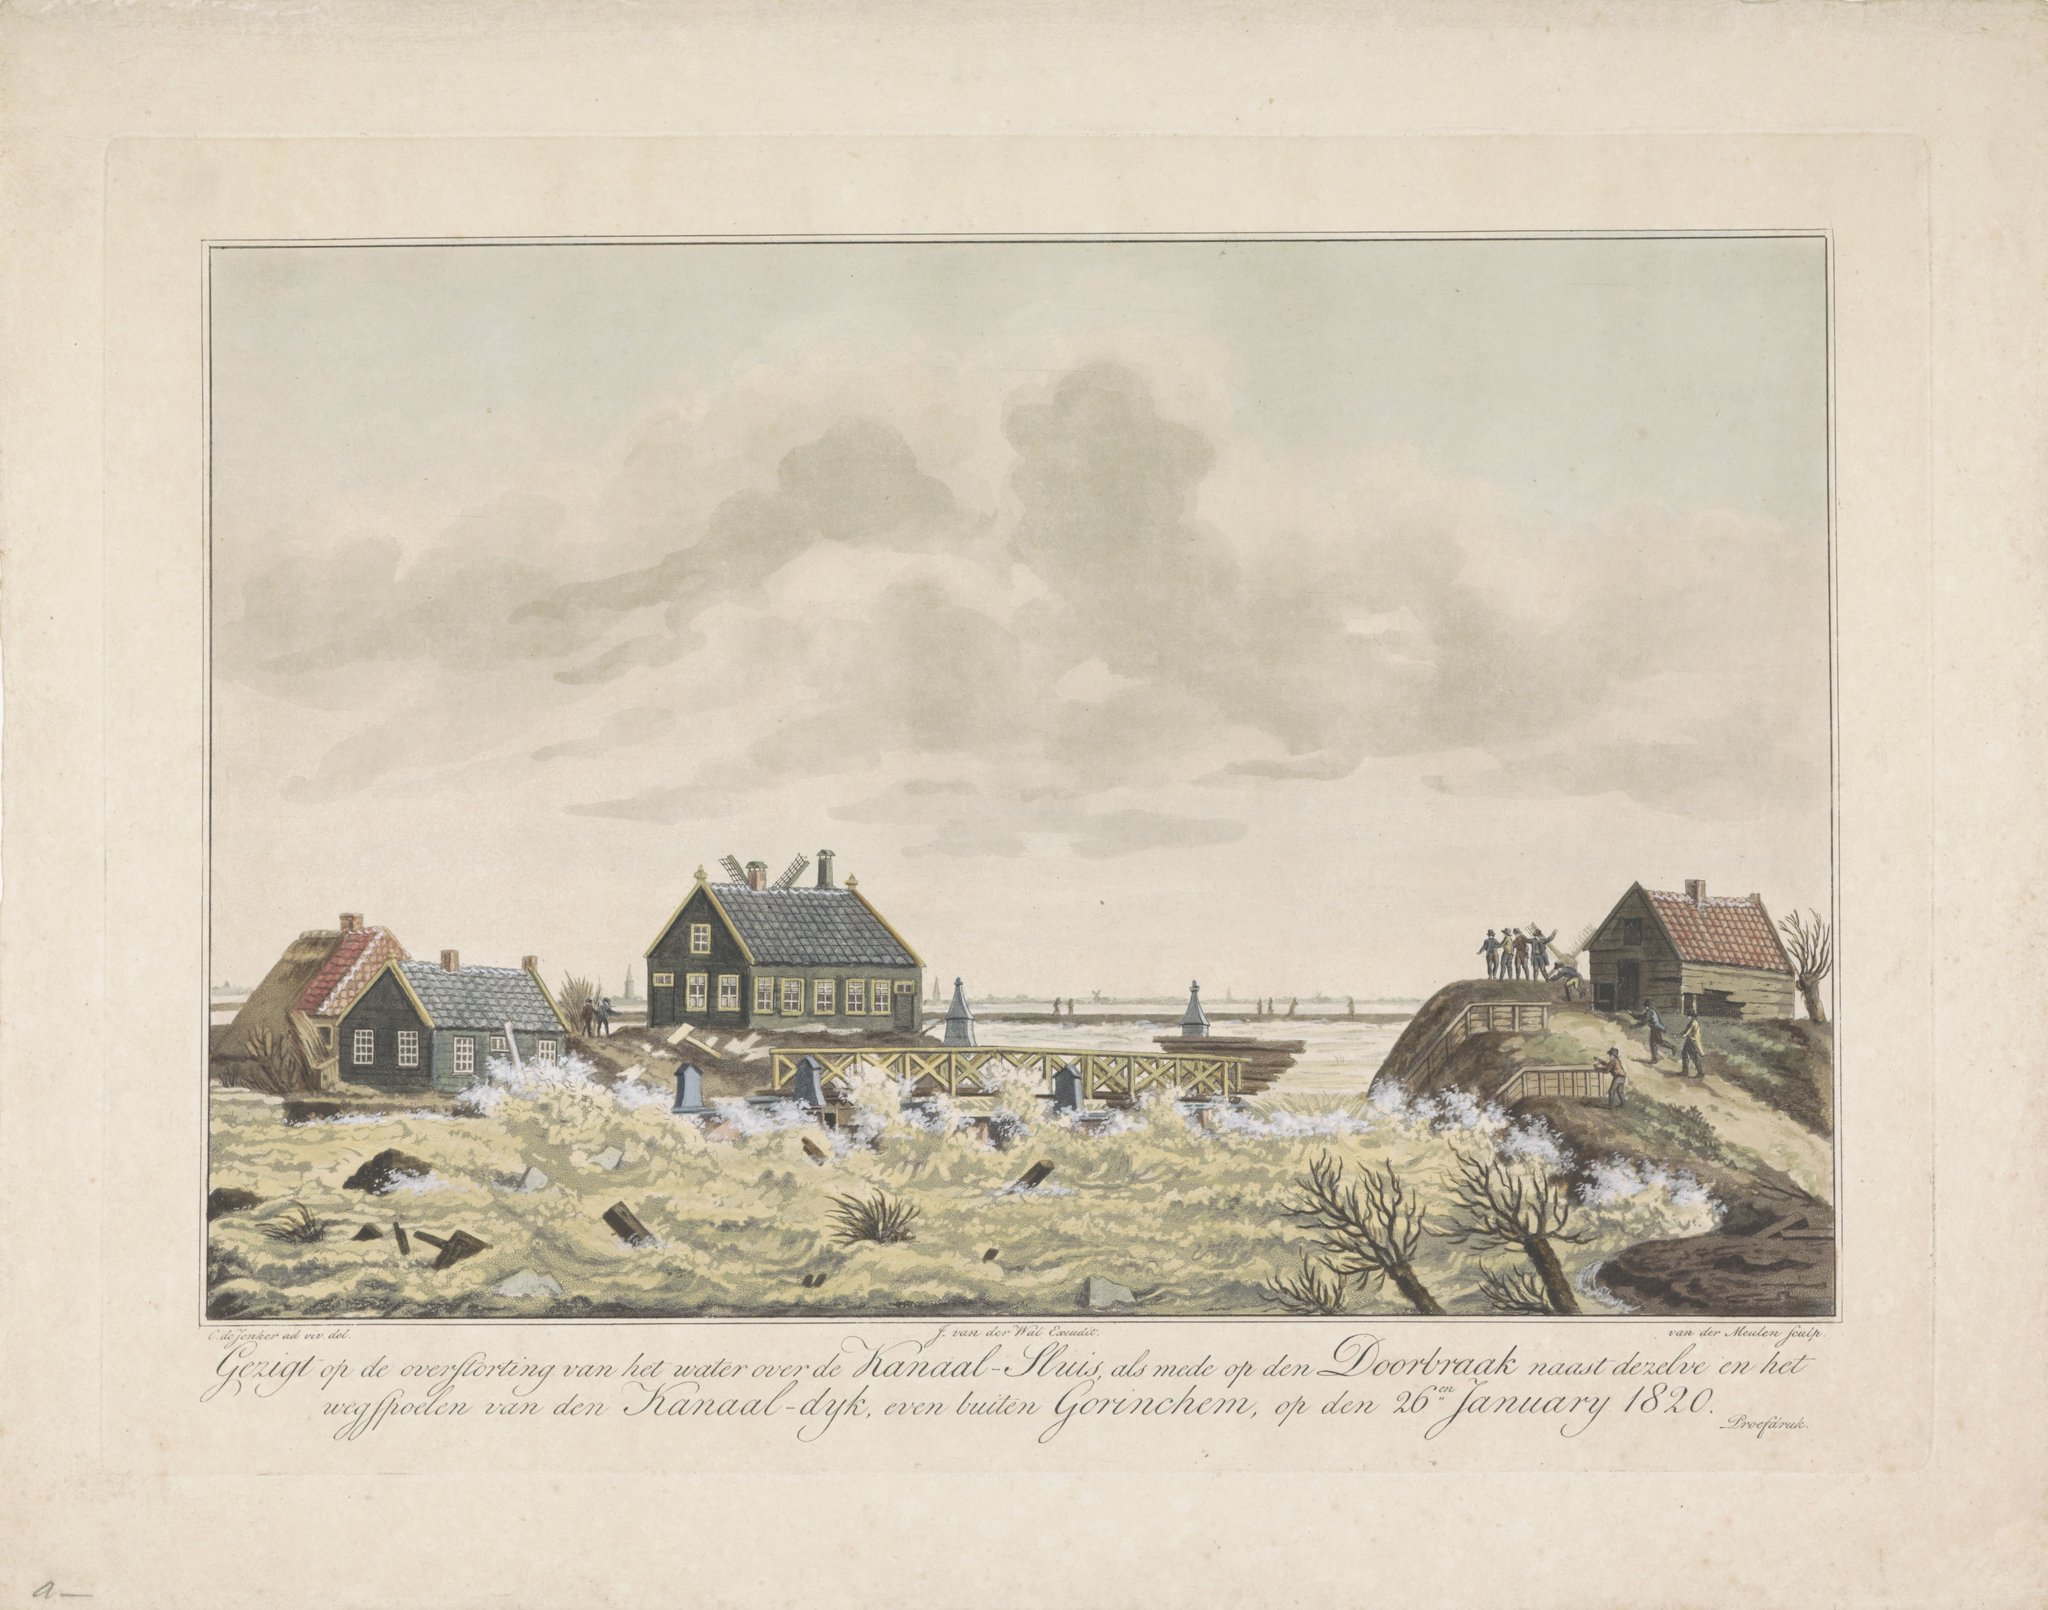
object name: print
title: Gezigt op de overstorting van het water over de Kanaal-Sluis, als mede op den Doorbraak naast dezelve en het wegspoelen van den Kanaal-dyk, even buiten Gorinchem, op den 26en January 1820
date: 1820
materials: paper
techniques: aquatint, etching, hand coloring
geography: gorinchem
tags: dike-break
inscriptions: collector's mark: Lugt 2228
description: Dijkdoorbraak en overstroming van de Kanaaldijk bij de sluis buiten Gorinchem op 26 januari 1820. Het water spoelt over de dijk. Links en rechts kijken mensen toe.